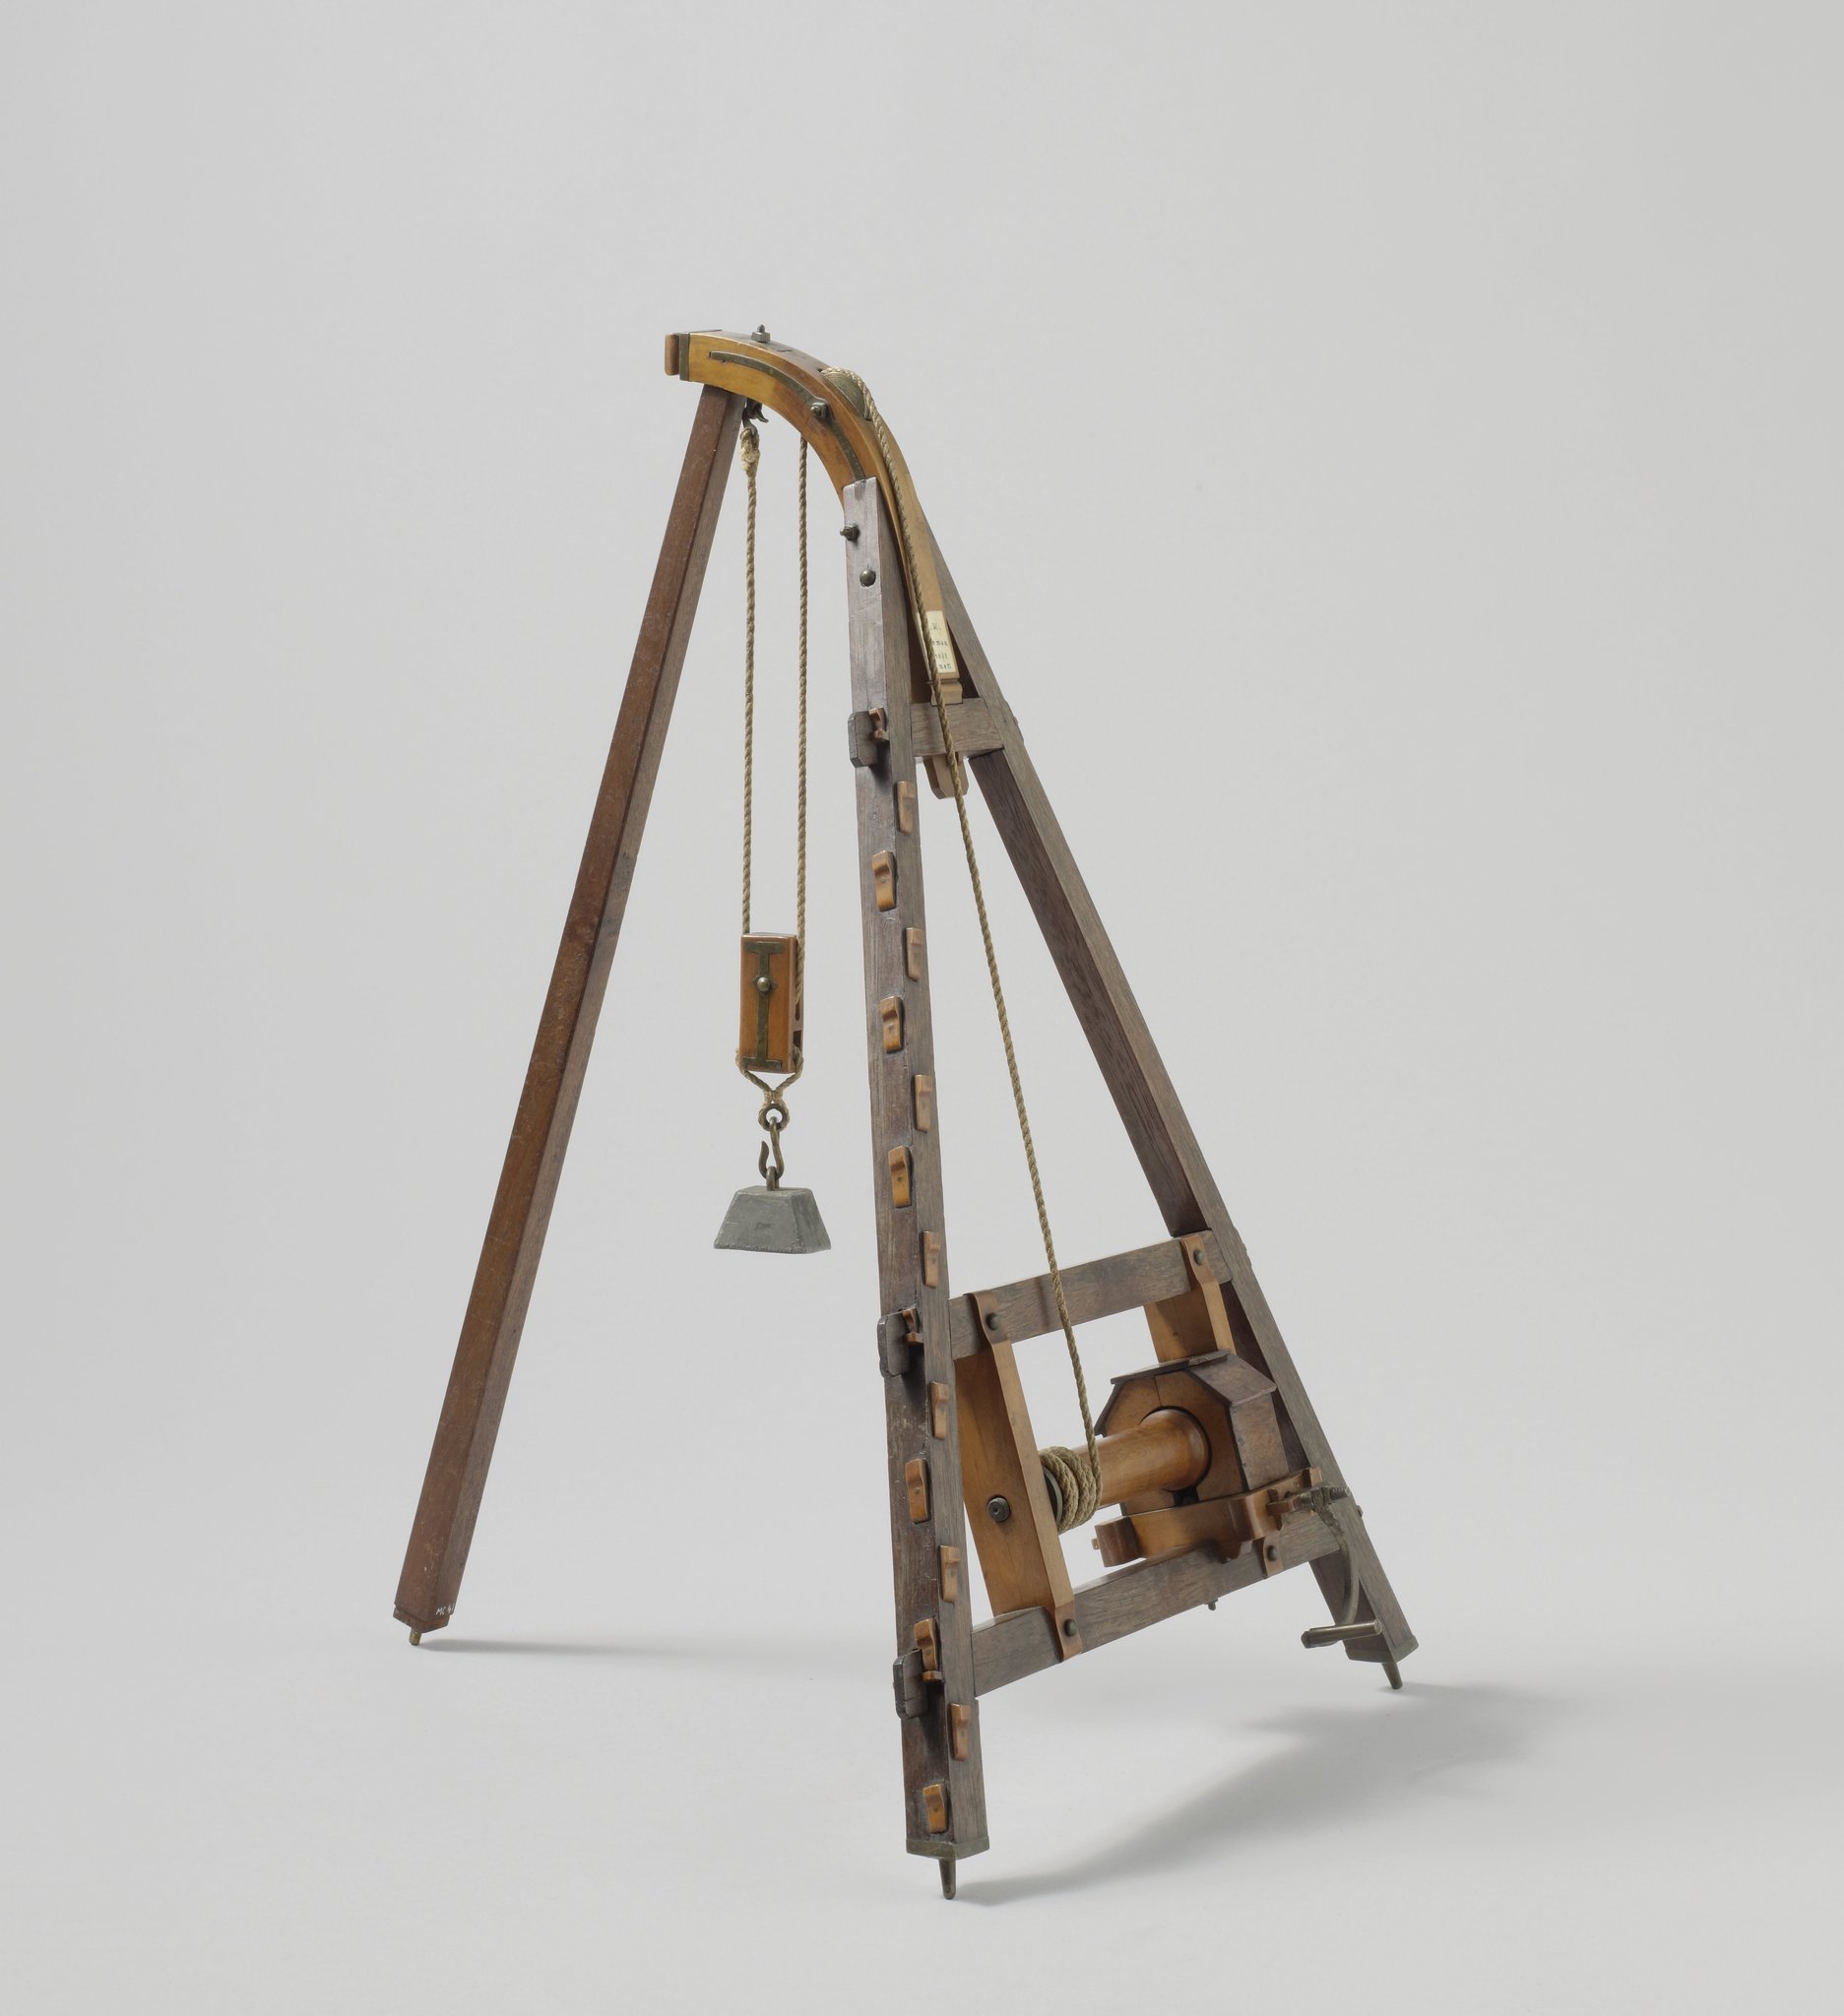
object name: demonstration model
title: Model of a Hoist or GIN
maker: jan marten kleman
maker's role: instrument maker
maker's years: 1758-1845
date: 1793-1807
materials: brass, copper, iron, ivory, lead, fiber, wood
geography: amsterdam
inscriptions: inscription, at the top: ‘j.M. / Kleman / fecit / Amst:’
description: Model van een samengestelde driepootbok: het mechanisme bestaat uit een zwengel met een schroef zonder eind, die de windas aandrijft. Het takel gaat van de as door een schijf in de top naar het zware blok waaraan een loden gewicht hangt, en terug naar de top. Eén van de achterpoten is voorzien van verspringende knietjes, waarschijnlijk voetsteunen voor het beklimmen van de bok.